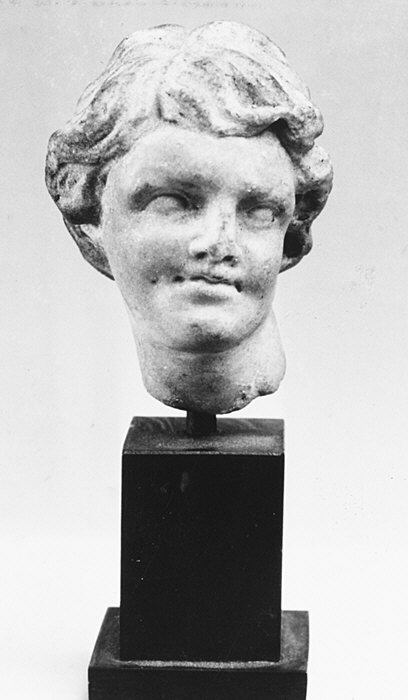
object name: head of a satyr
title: Small marble head of a youth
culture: roman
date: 1-200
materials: marble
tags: heads,boys